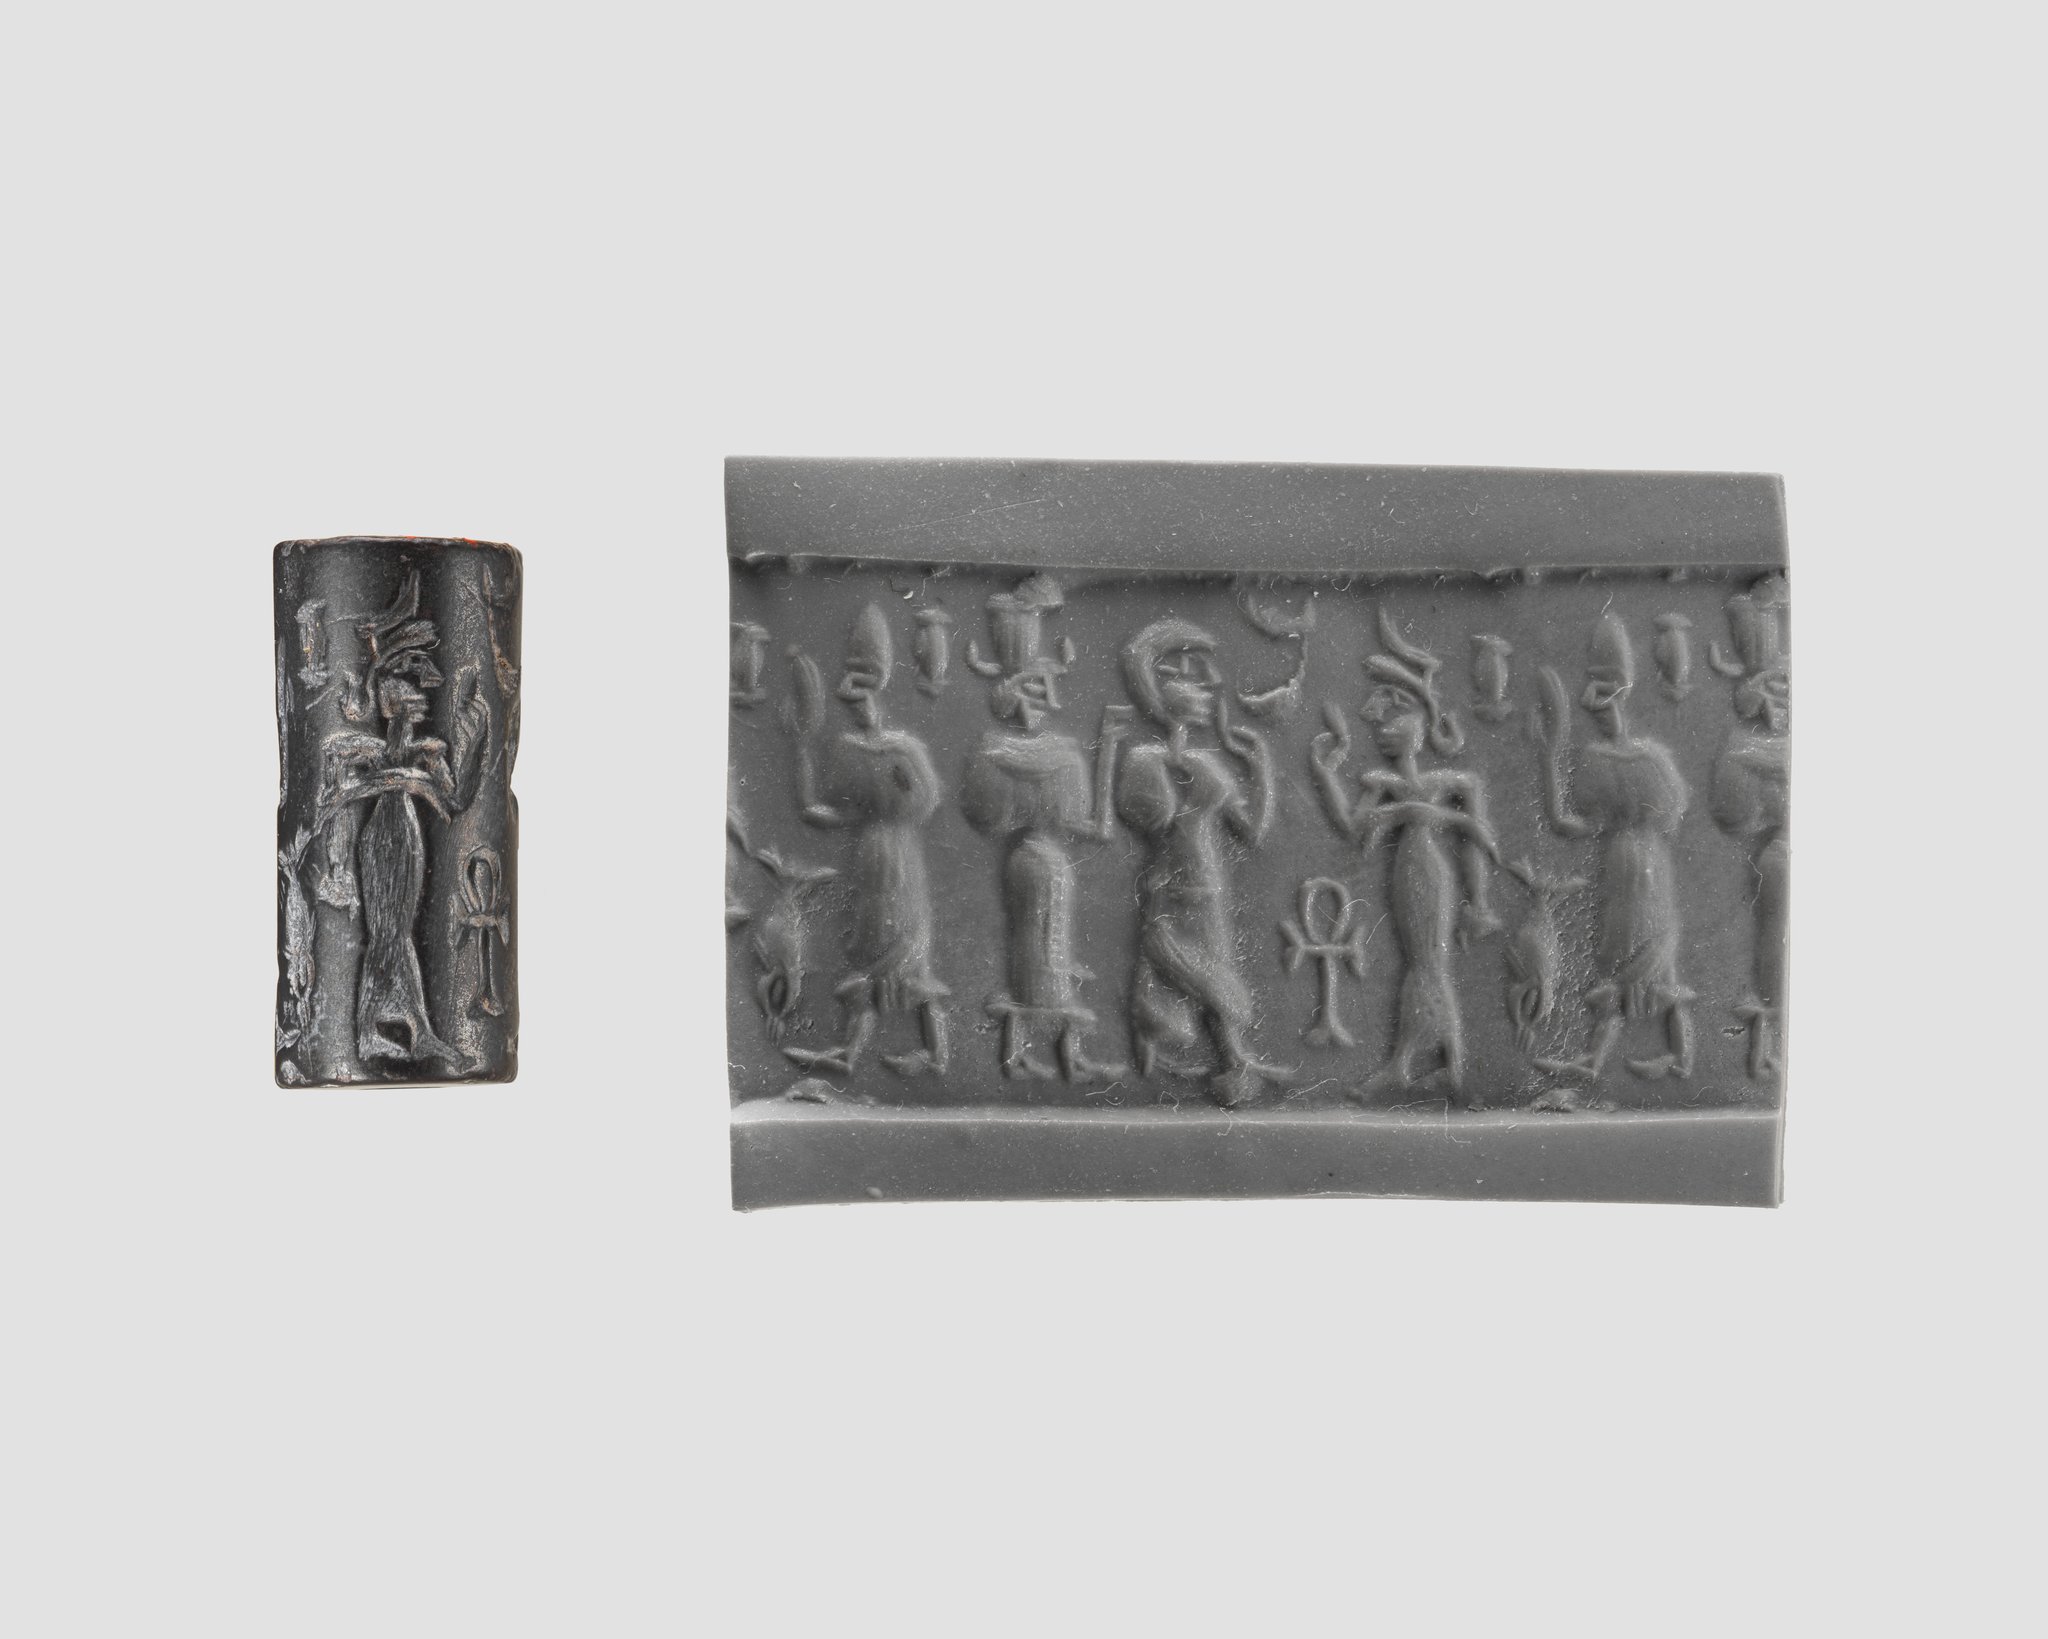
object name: cylinder seal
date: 1720-1650 BCE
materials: mineral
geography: syria